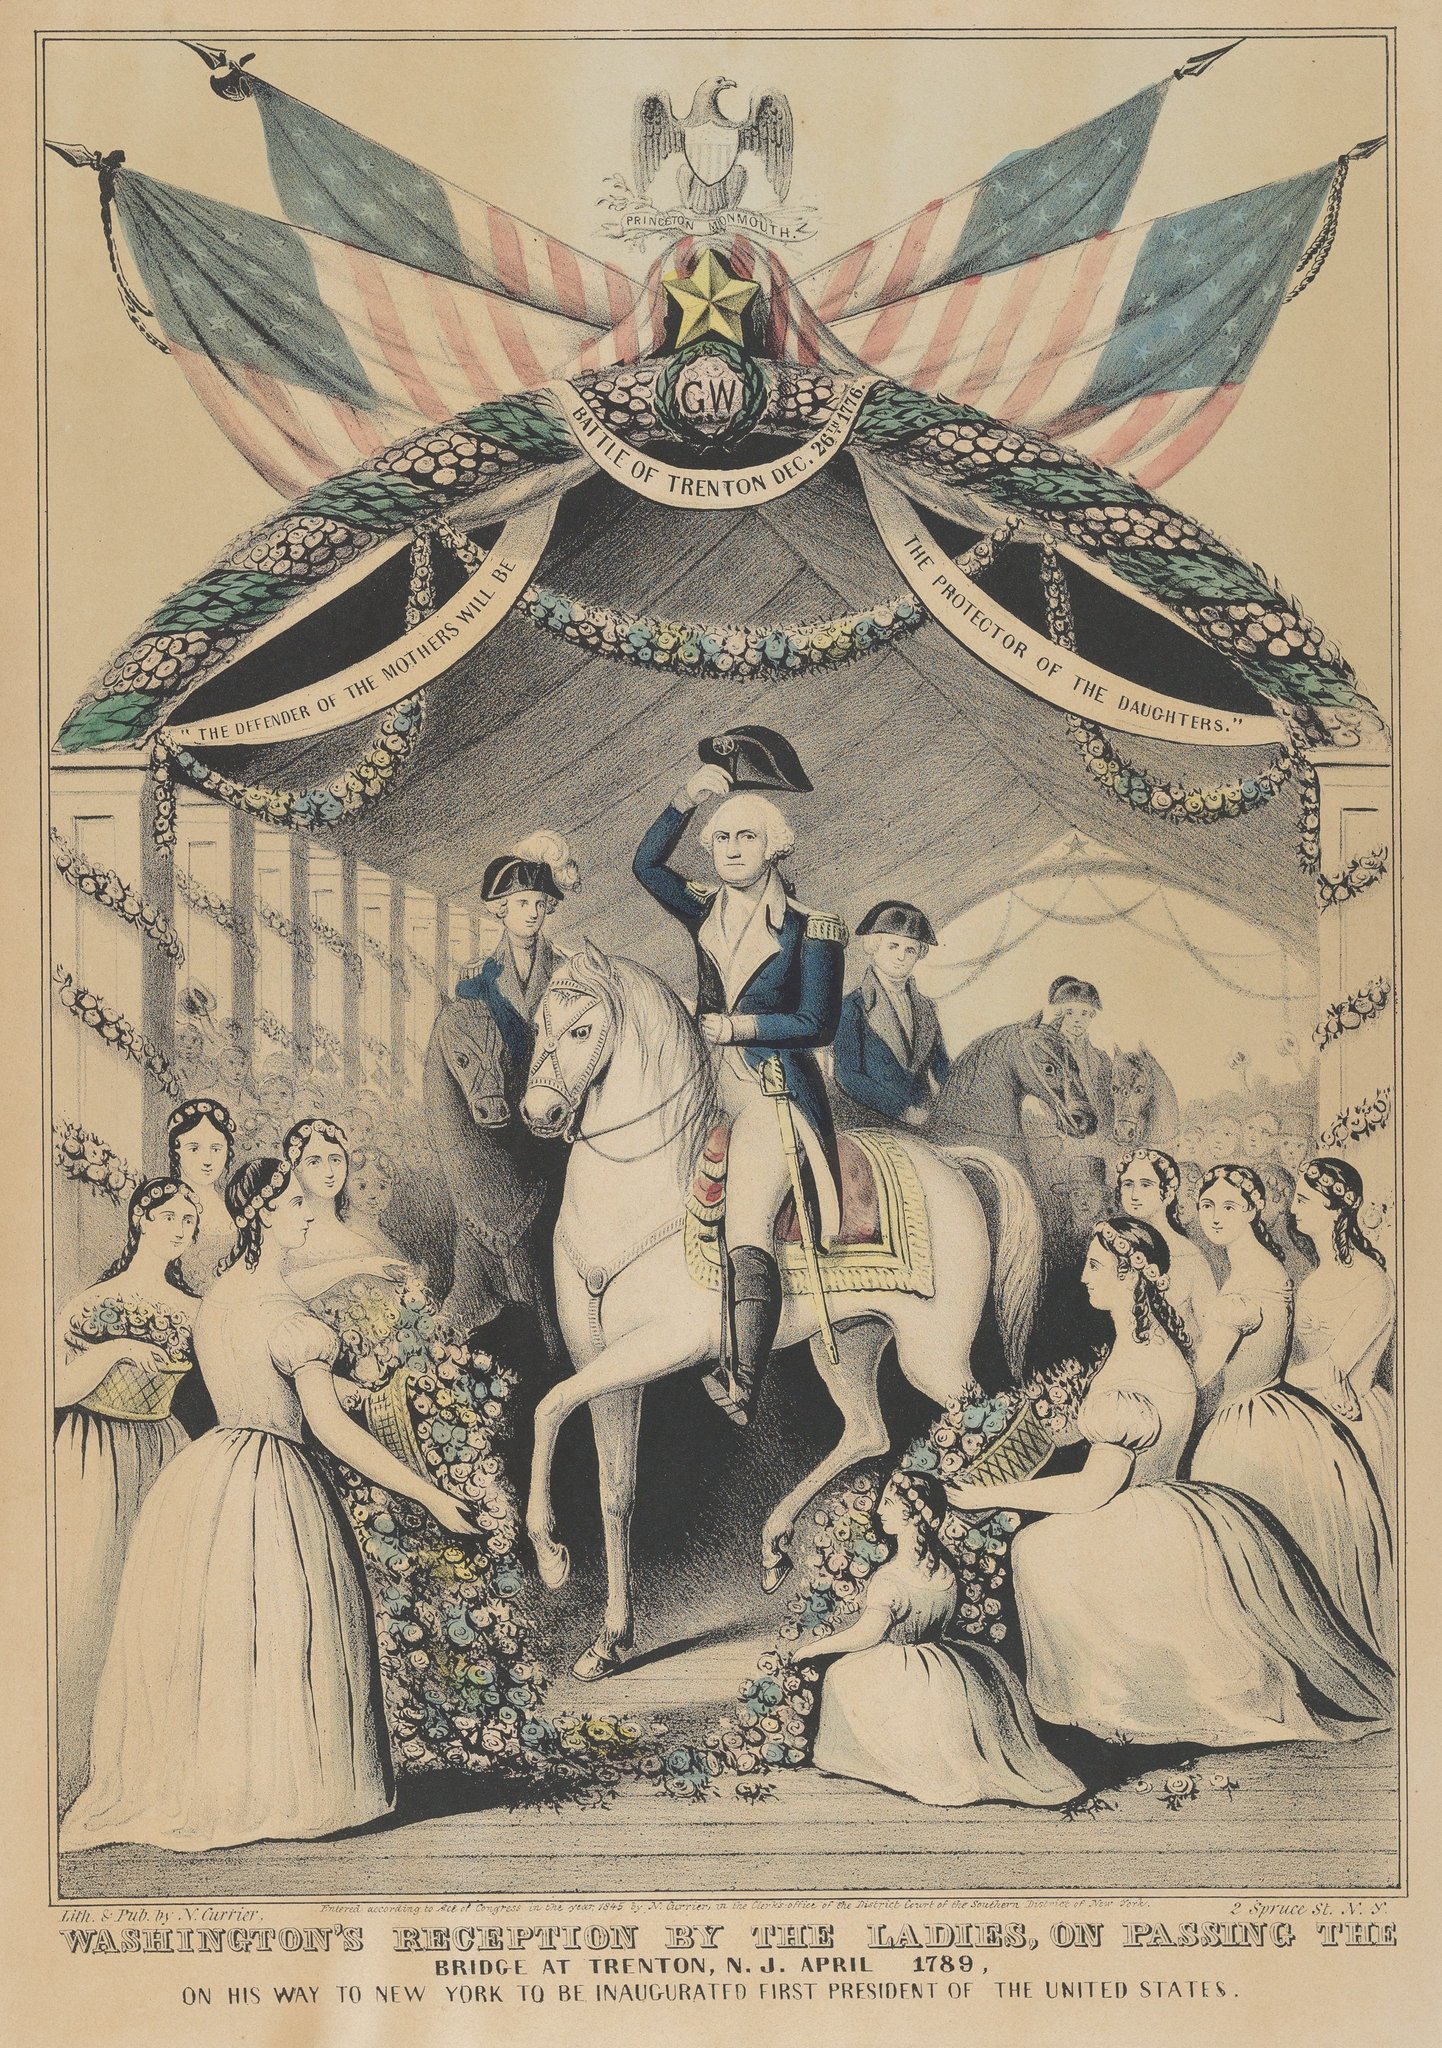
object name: print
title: Washington's Reception by the Ladies on Passing the Bridge at Trenton, N.J., April 1789, on His Way to be Inaugurated First President of the United States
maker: nathaniel currier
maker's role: publisher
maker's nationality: american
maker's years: 1813-1888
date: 1845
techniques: hand coloring, lithograph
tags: eagles,george washington,women,horses,flags